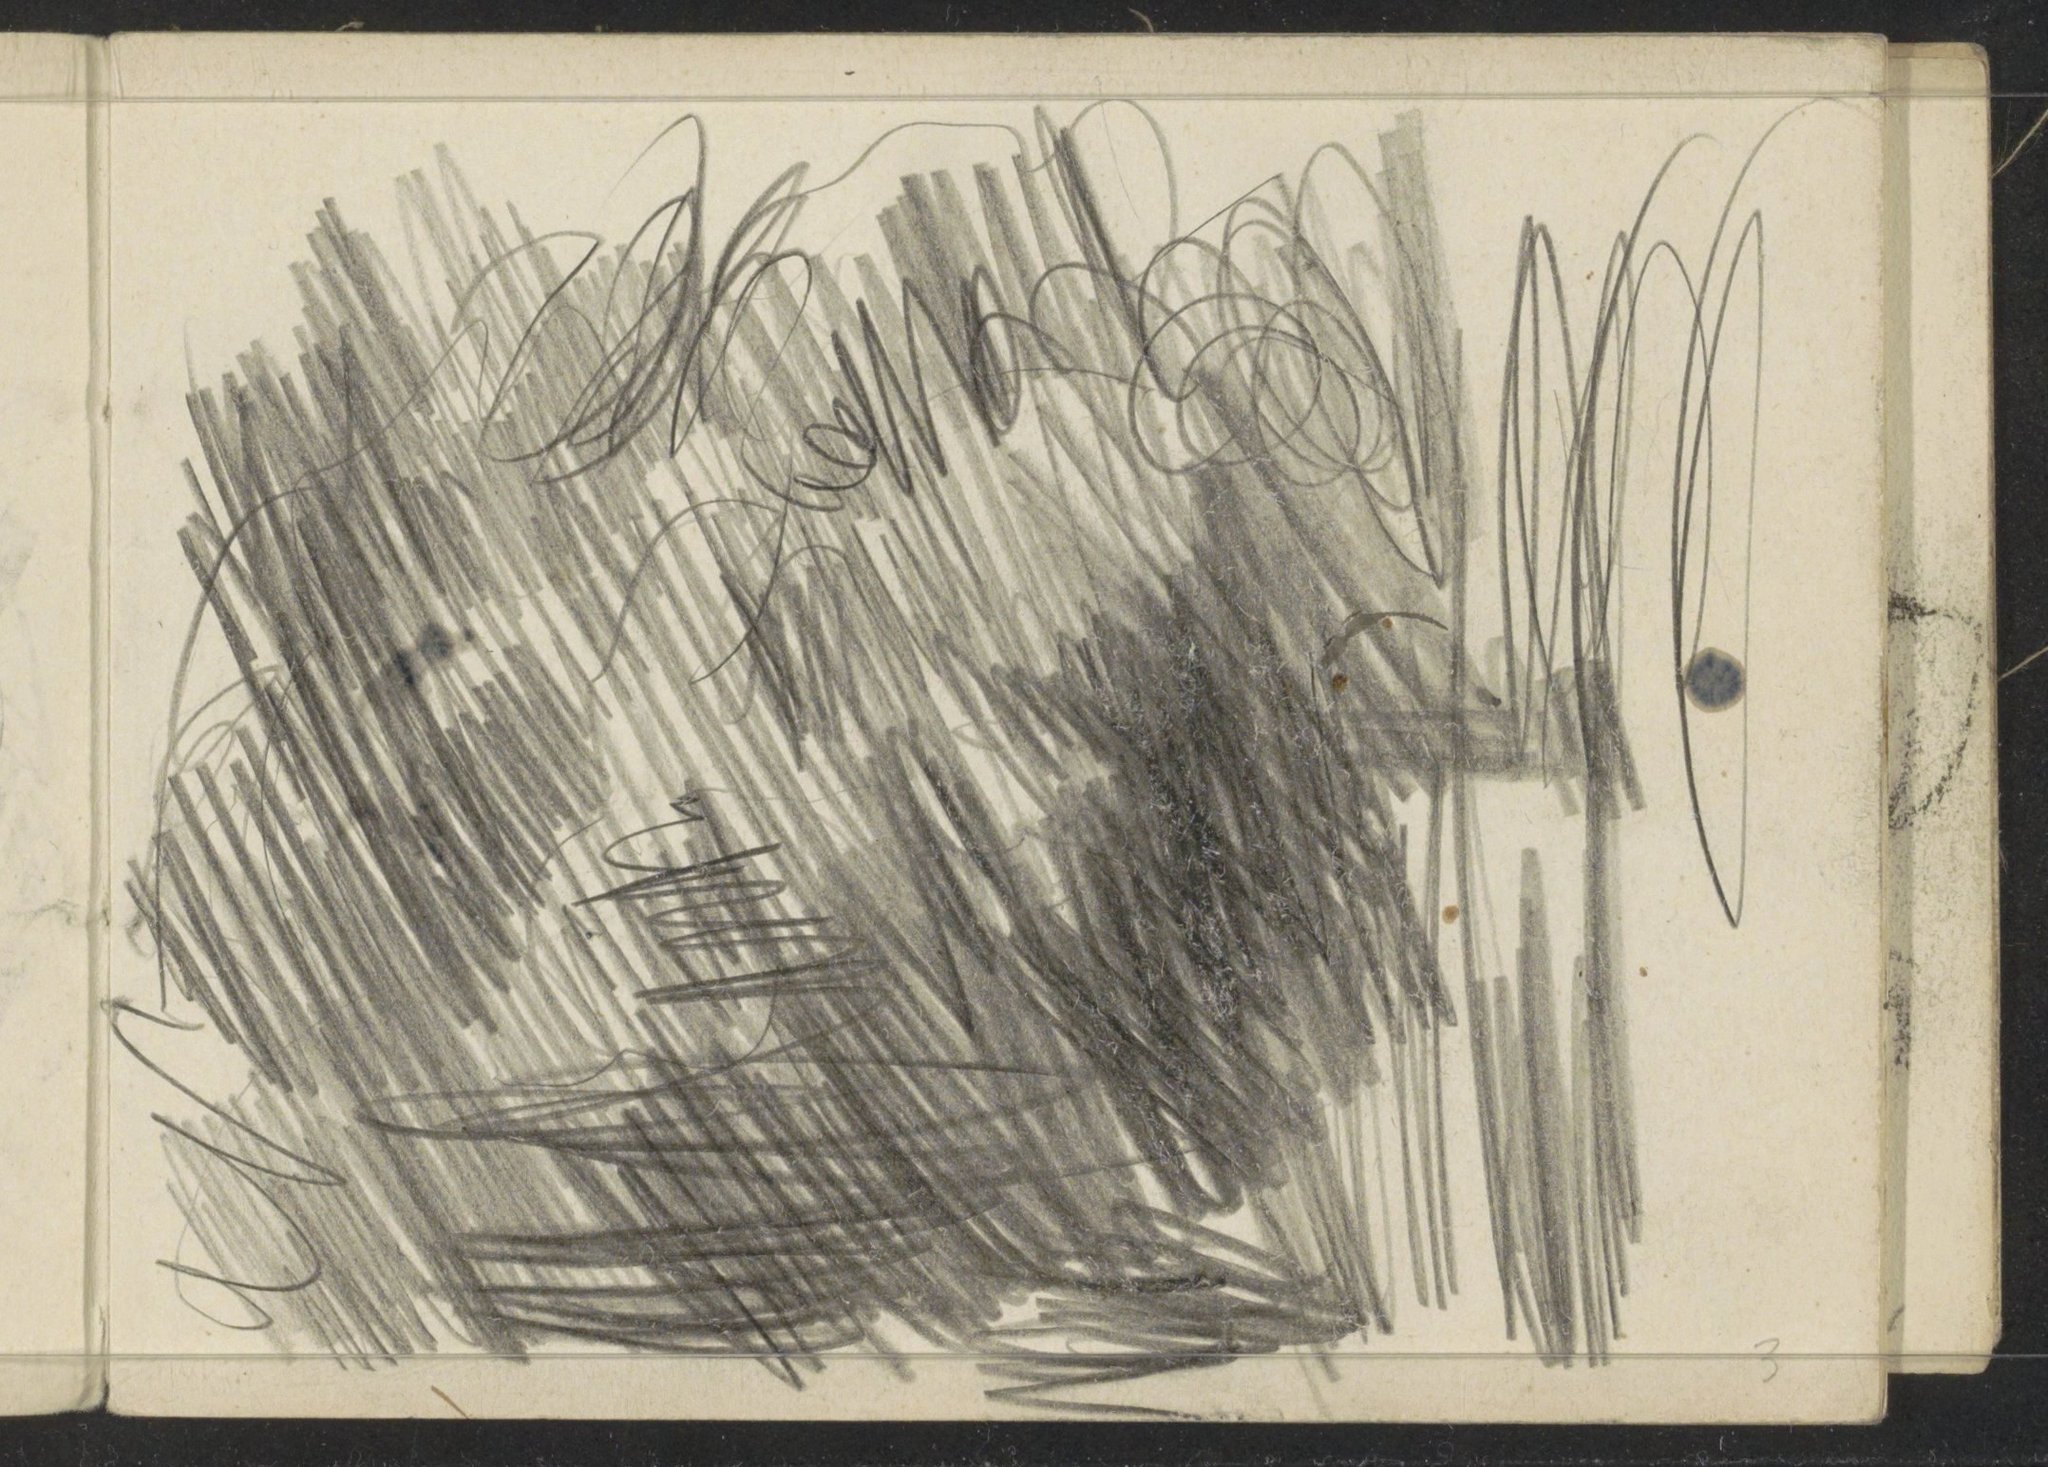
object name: sketchbook leaf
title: Boom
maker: isaac israels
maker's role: draughtsman, painter, print maker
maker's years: 1865-1934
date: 1923-1934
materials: paper, pencil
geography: the hague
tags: trees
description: Blad 3 recto uit schetsboek LVIII met 14 bladen.